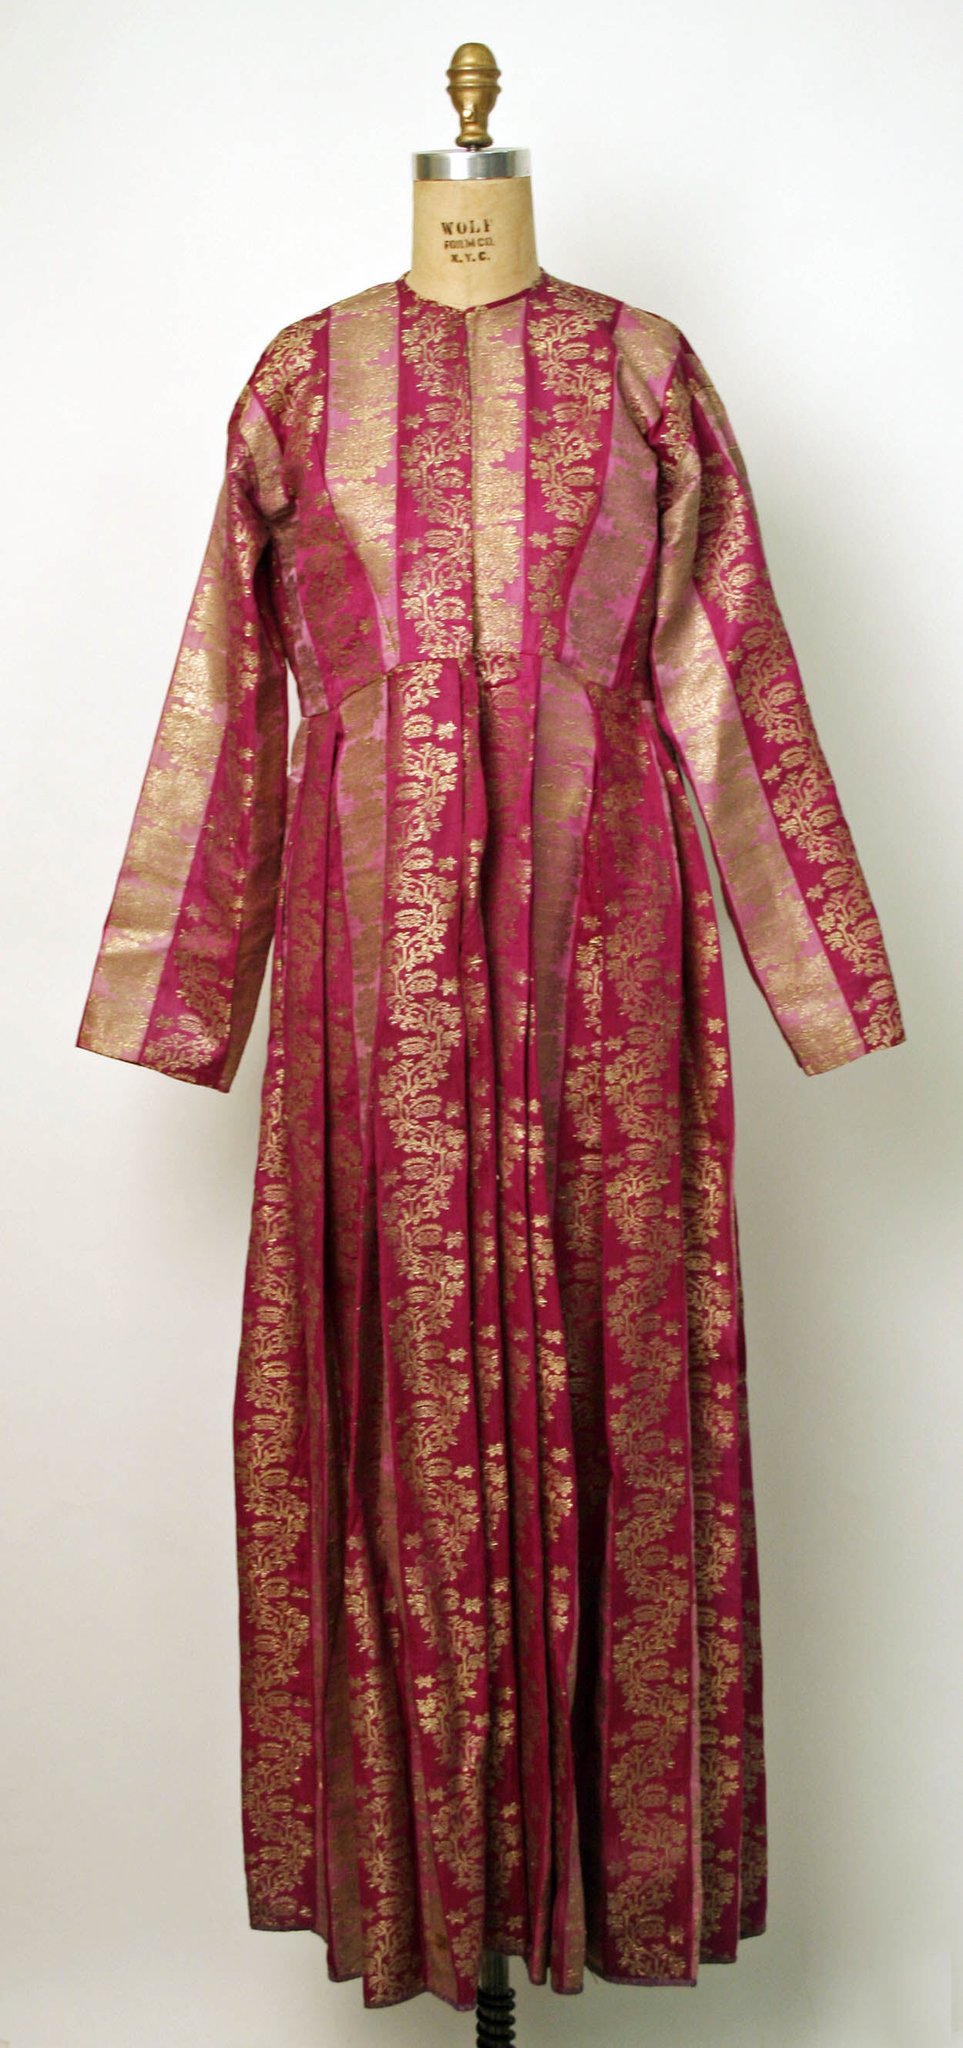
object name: dress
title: Festive Dress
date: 1881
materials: metal thread, silk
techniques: weave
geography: turkey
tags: dresses